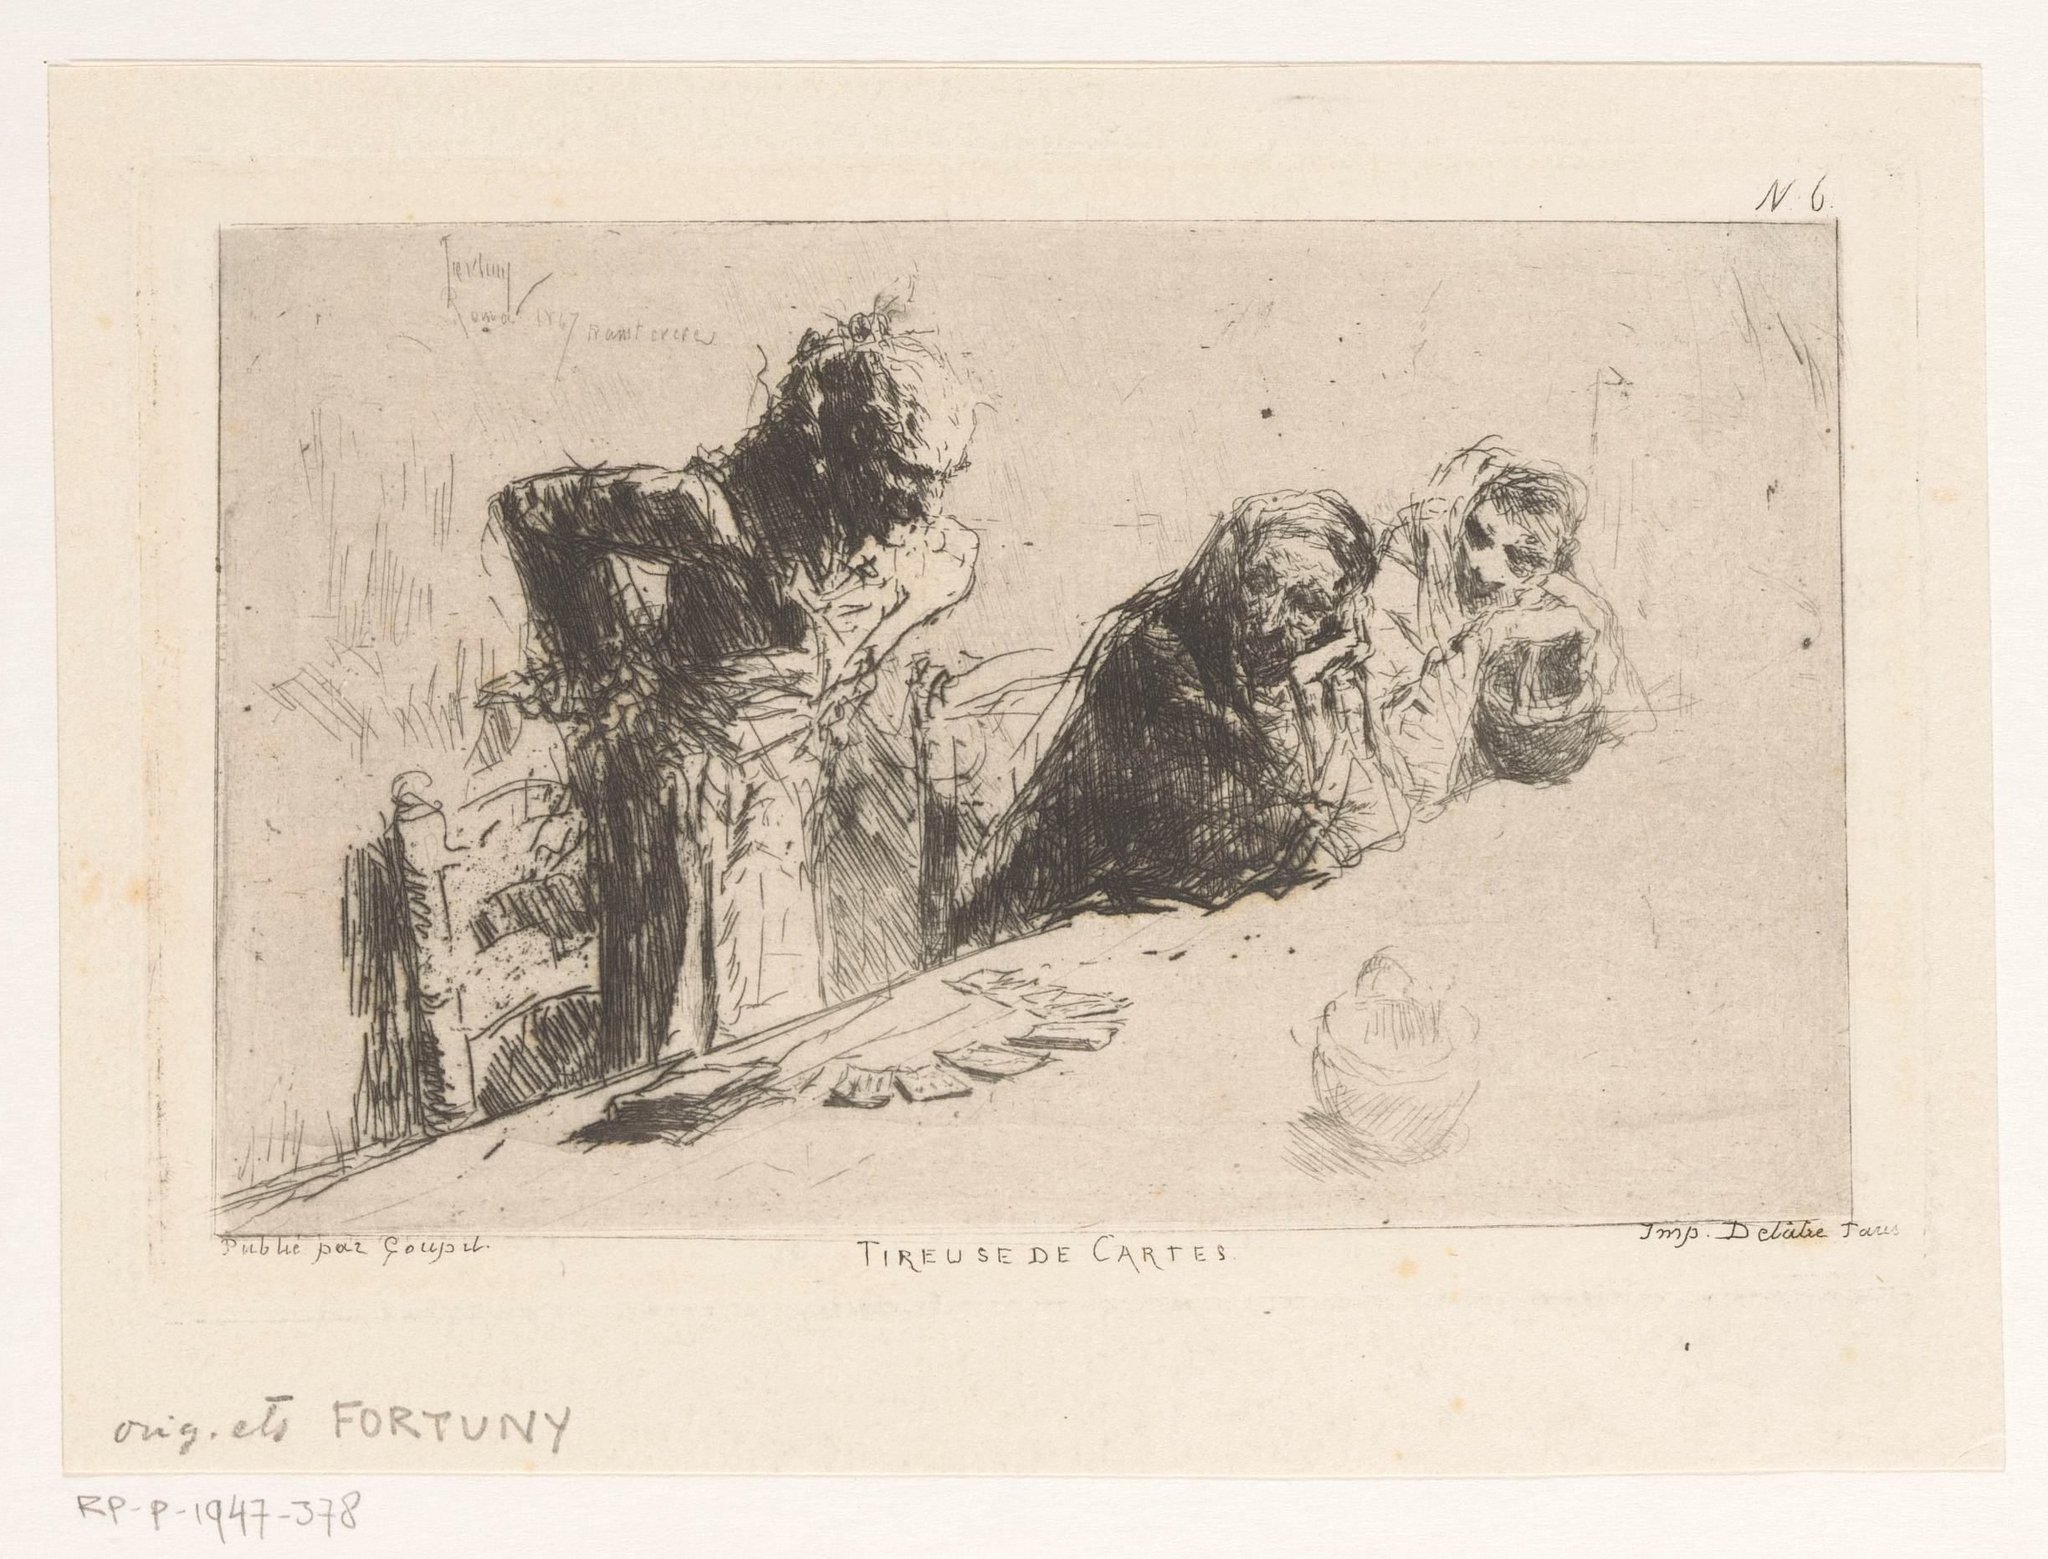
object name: print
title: Drie kaartende mannen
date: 1867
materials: paper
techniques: etching, intaglio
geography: rome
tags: playing-cards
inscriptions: collector's mark: Lugt 2228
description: Drie mannen zittend aan een tafel met daarop een kaartspel.